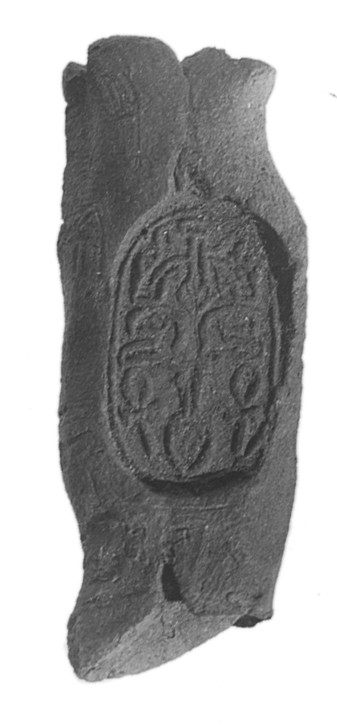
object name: sealing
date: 2030-1640 BCE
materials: clay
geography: egypt